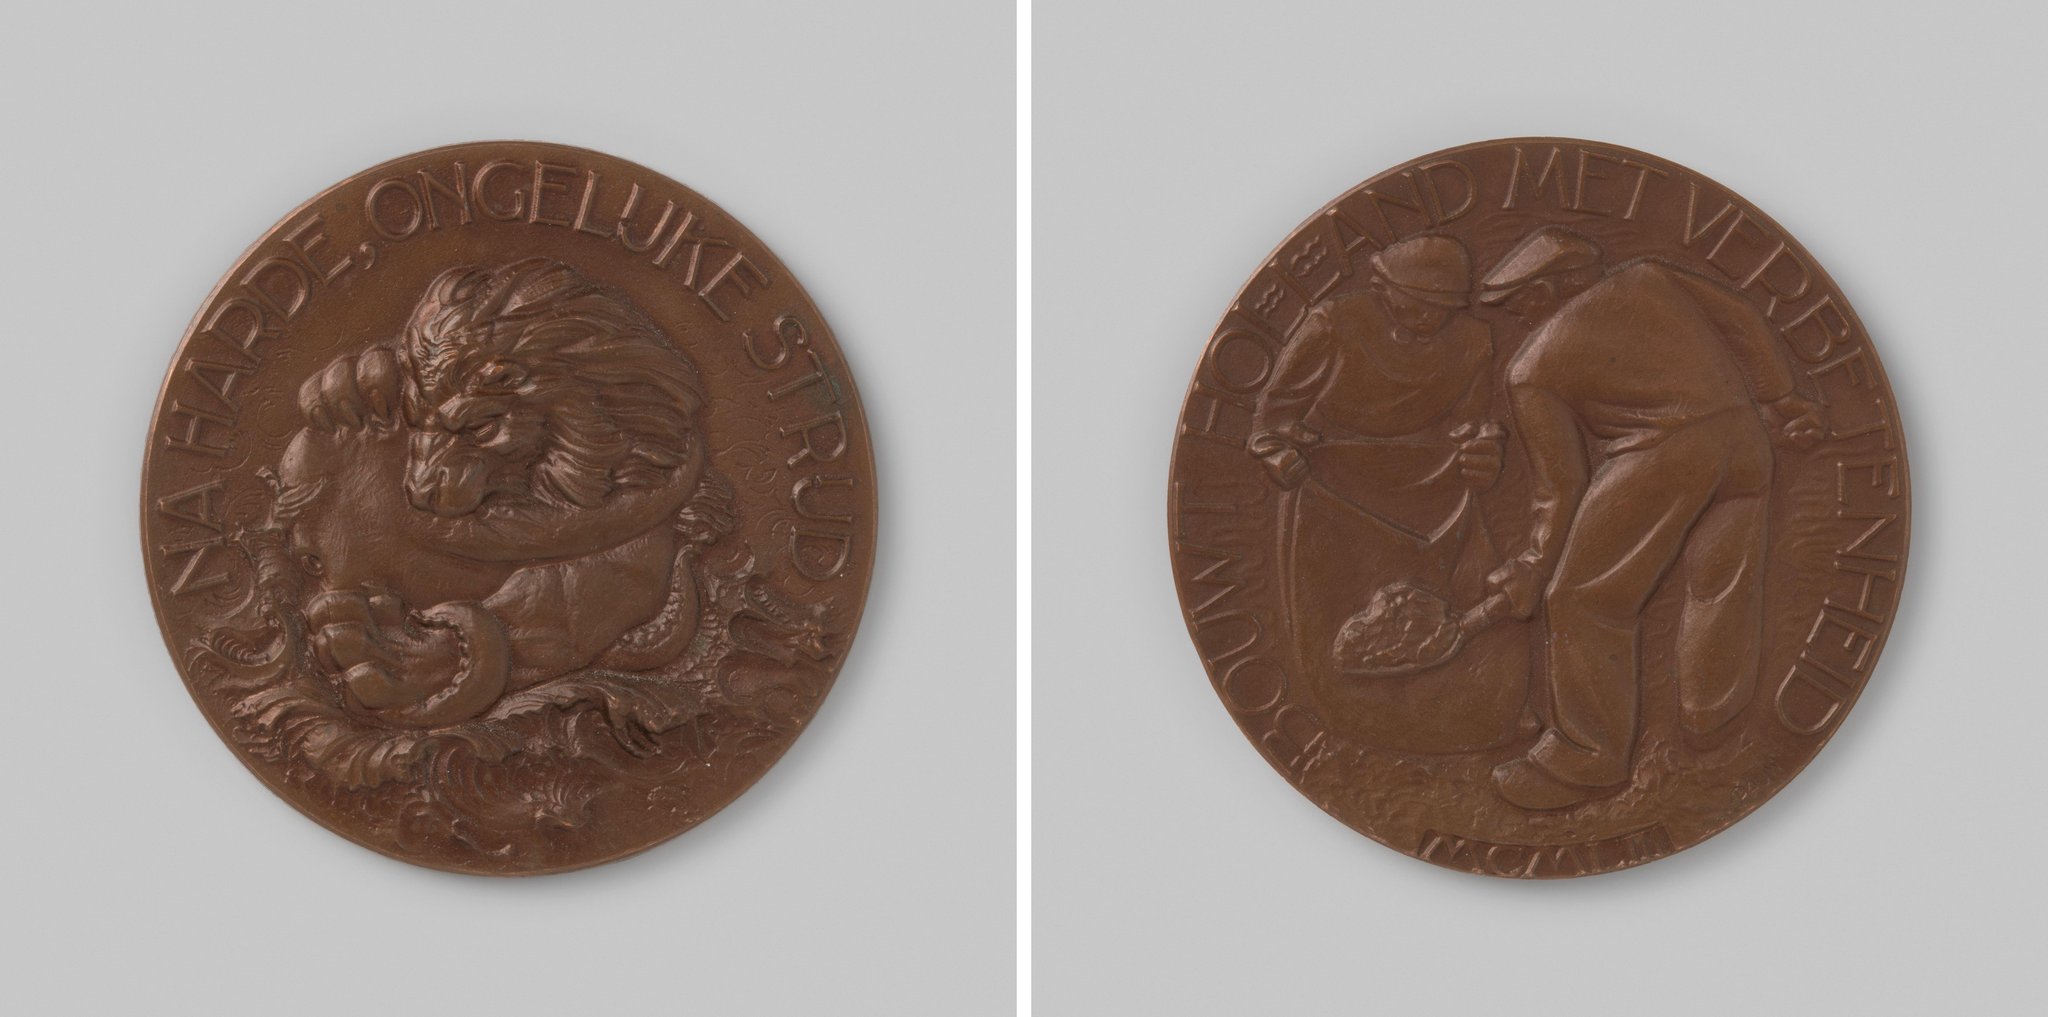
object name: history medal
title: Watersnood 1953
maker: maarten pauw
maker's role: designer, sculptor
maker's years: 1912-1966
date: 1953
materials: bronze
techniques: striking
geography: netherlands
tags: netherlands, north sea flood of 1953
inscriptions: date: ‘MCMLIII’, circumscription: ‘NA HARDE ONGELIJKE STRIJD’, circumscription: ‘BOUWT HOLLAND MET VERBETENHEID’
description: Bronzen penning. Voorzijde: de Nederlandse Leeuw die het watermonster verslaat. Keerzijde: een boer en boerin aan het werk.